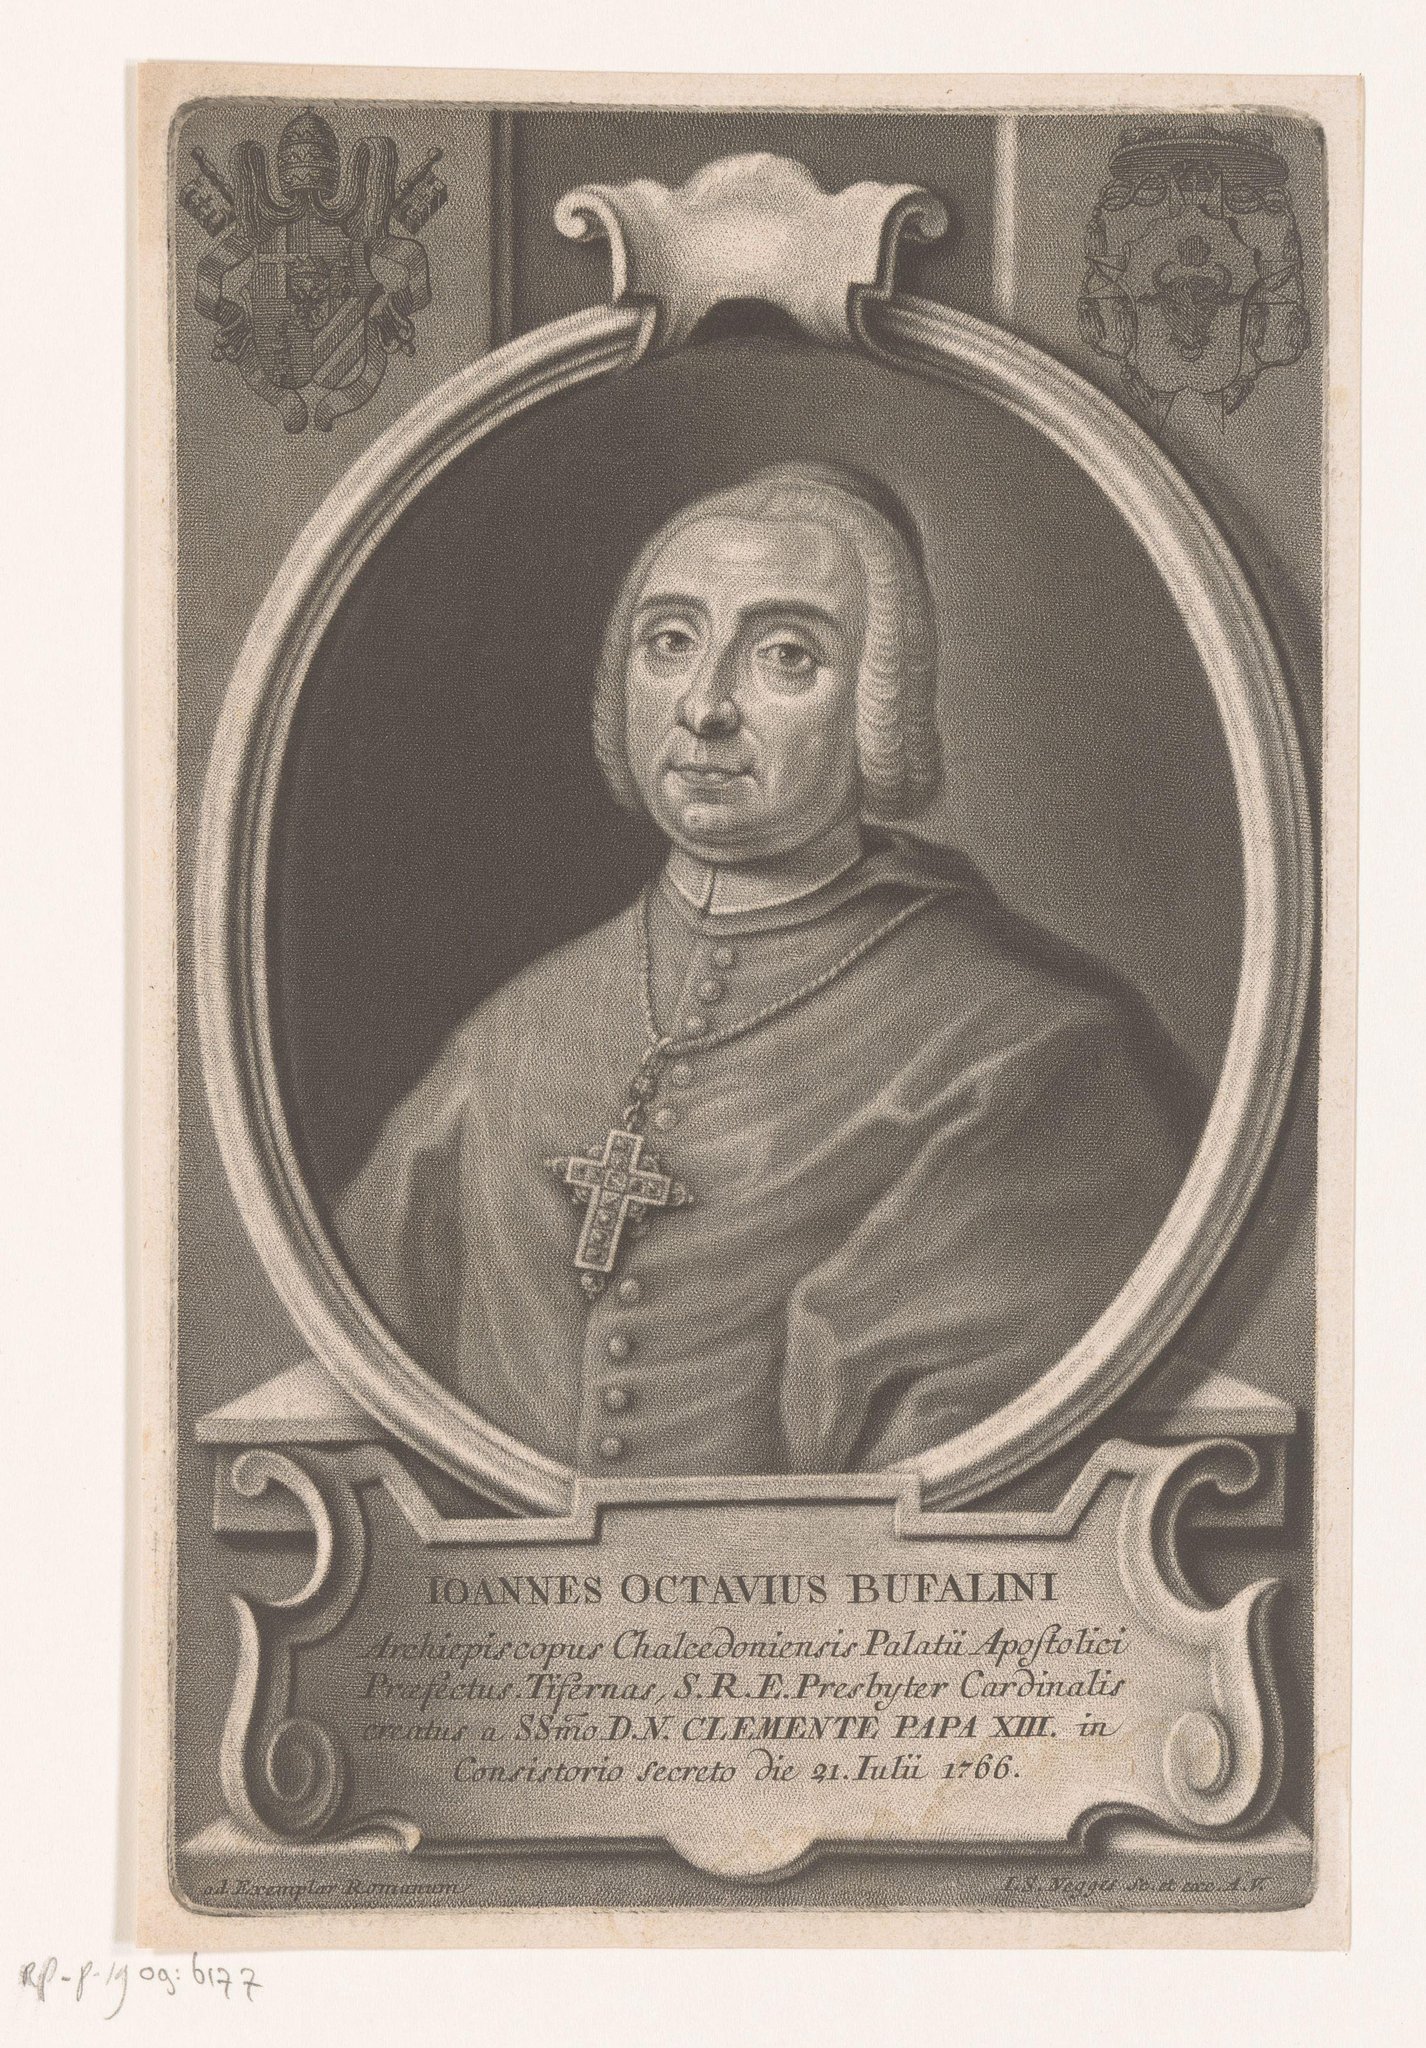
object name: print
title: Portret van Giovanni Ottavio Bufalini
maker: johann simon negges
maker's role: print maker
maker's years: 1726-1792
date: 1736-1792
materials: paper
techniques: mezzotint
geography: augsburg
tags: historical persons, armorial bearing, heraldry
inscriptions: collector's mark: Lugt 2228